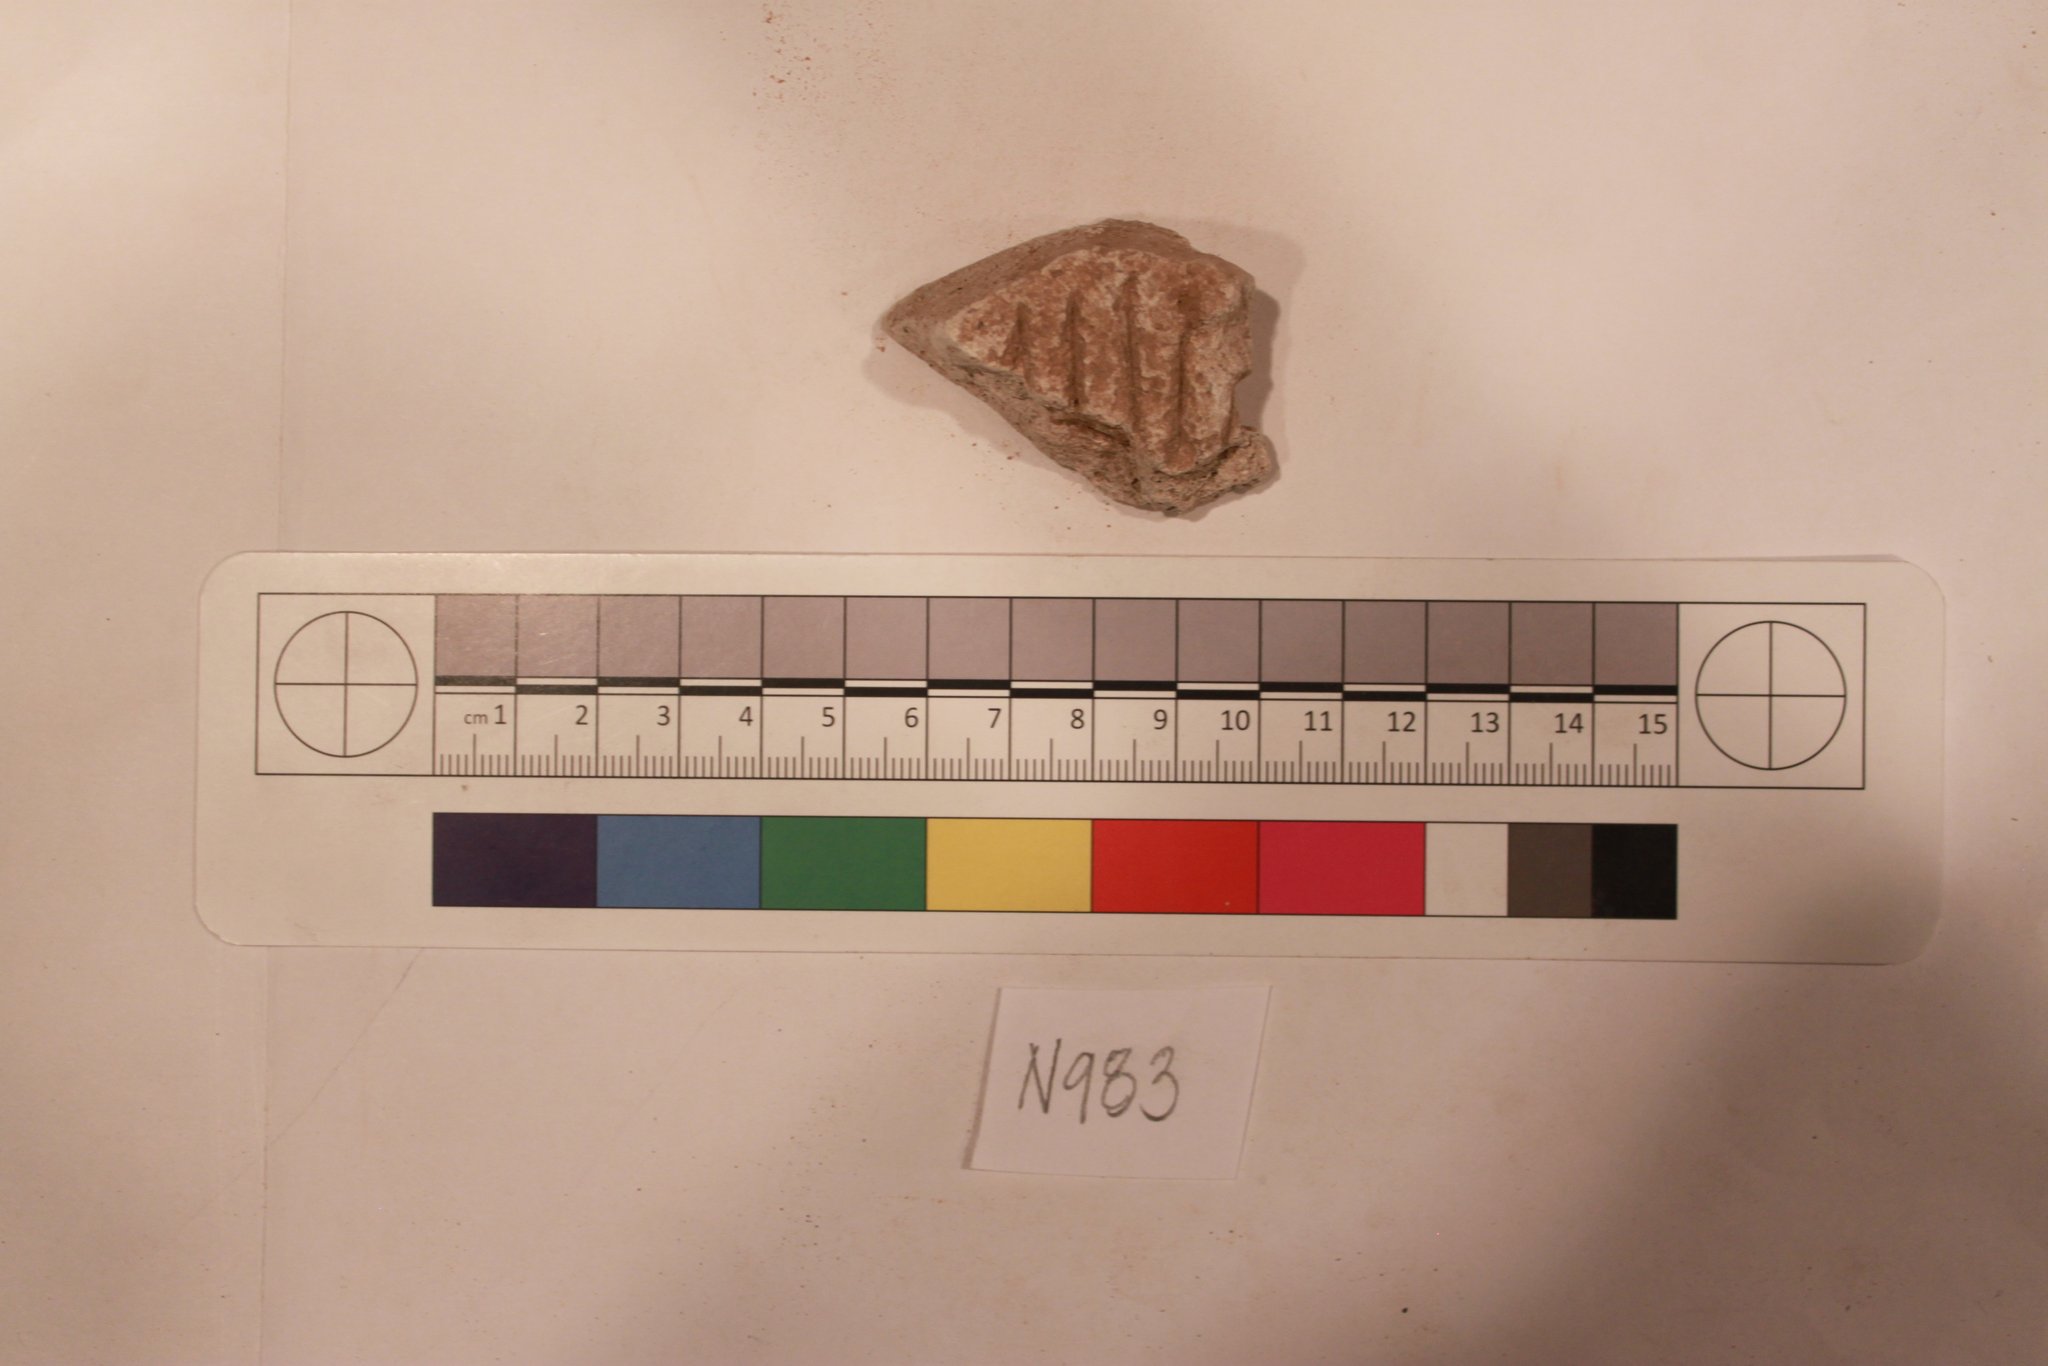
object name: fragment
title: Stucco Fragment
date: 701-1200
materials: plaster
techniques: carving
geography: iran